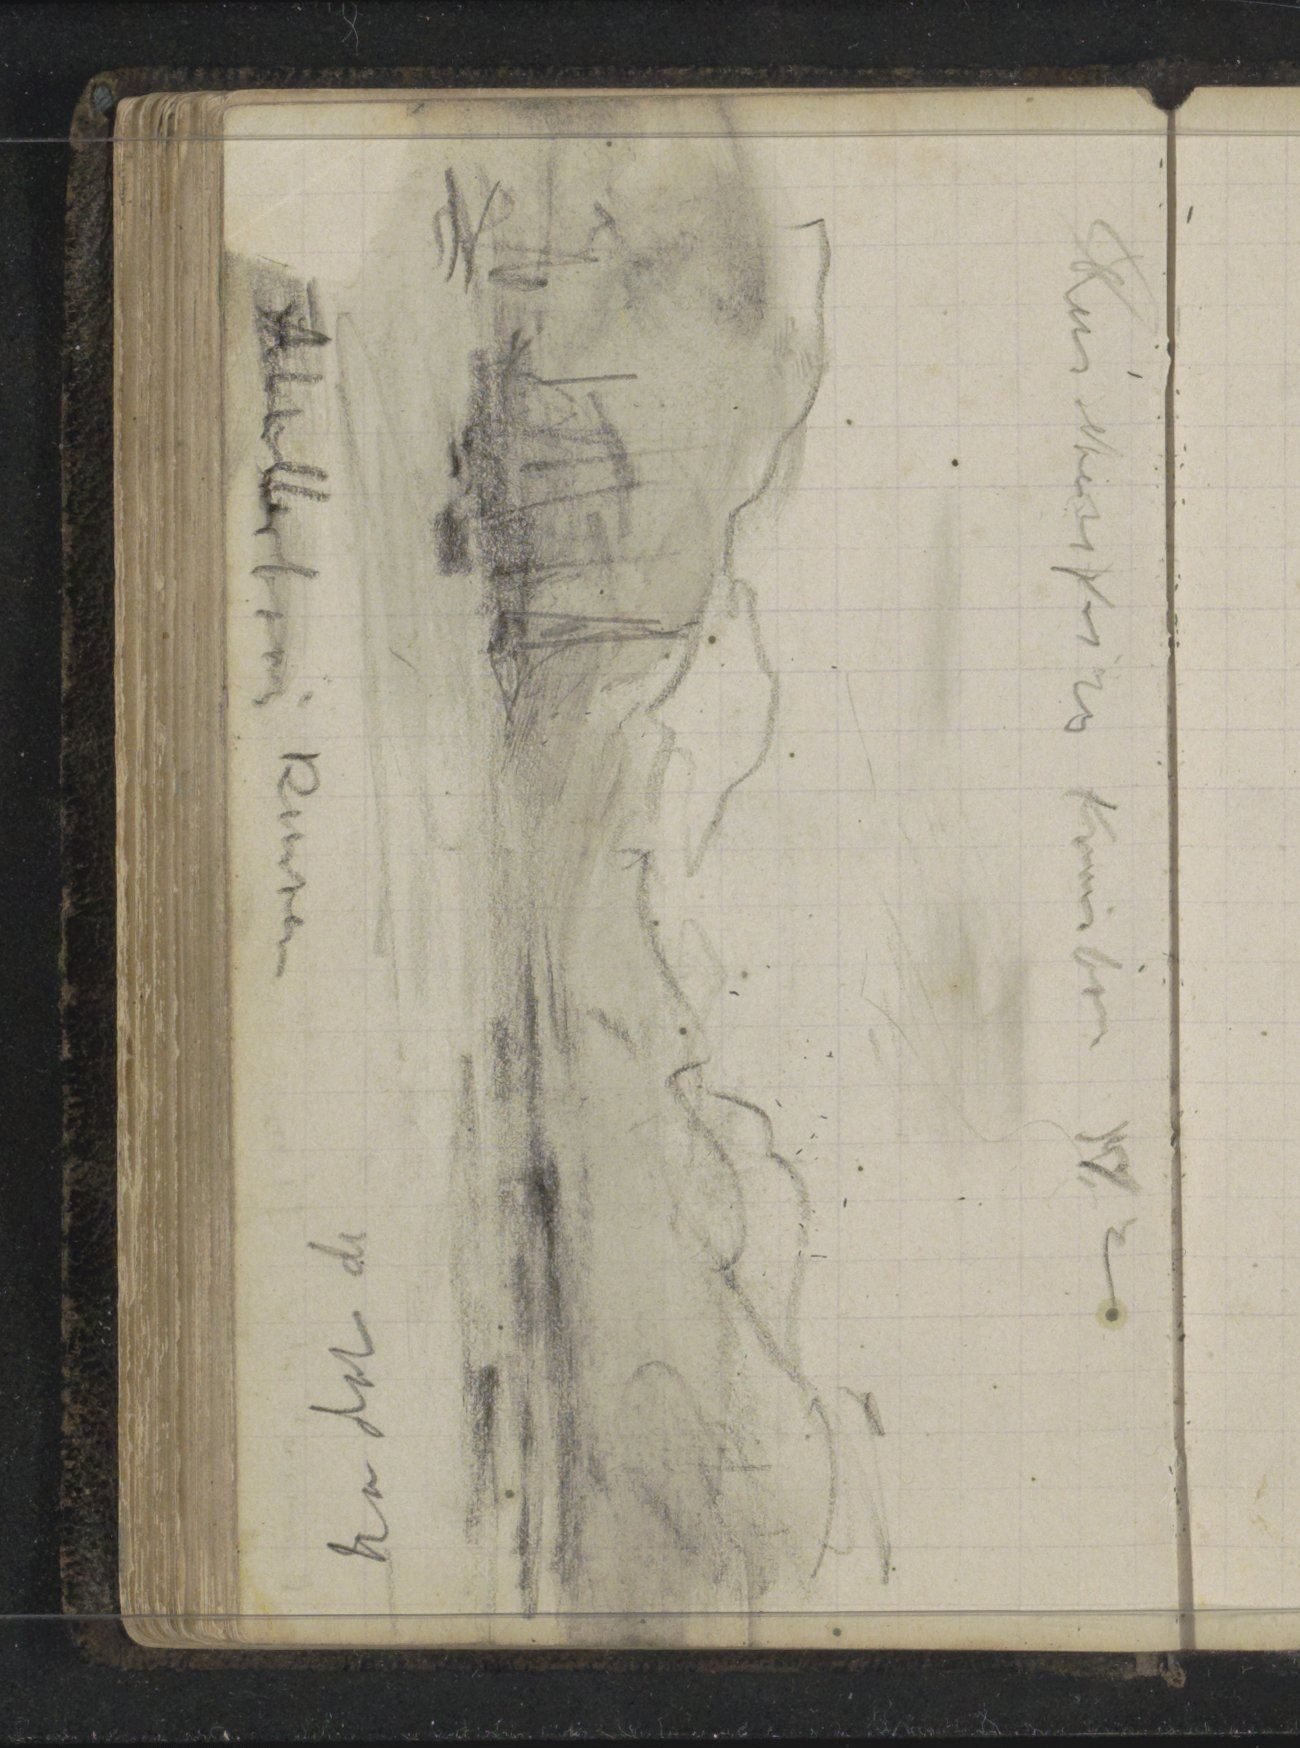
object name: sketchbook leaf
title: Russische zeilschepen in de Kruisbaai te Nova Zembla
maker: louis apol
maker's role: draughtsman, painter, print maker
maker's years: 1850-1936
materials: chalk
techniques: brush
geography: kruisbaai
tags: gulf, bay, sailing-ship, sailing-boat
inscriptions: annotation: ‘Russchen [...] Kruisbaai N.Z. / [...]llerbaai Russen [...]’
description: Blad 56 verso uit een schetsboek met 110 bladen betekend tijdens de expeditie naar Nova Zembla in 1880.